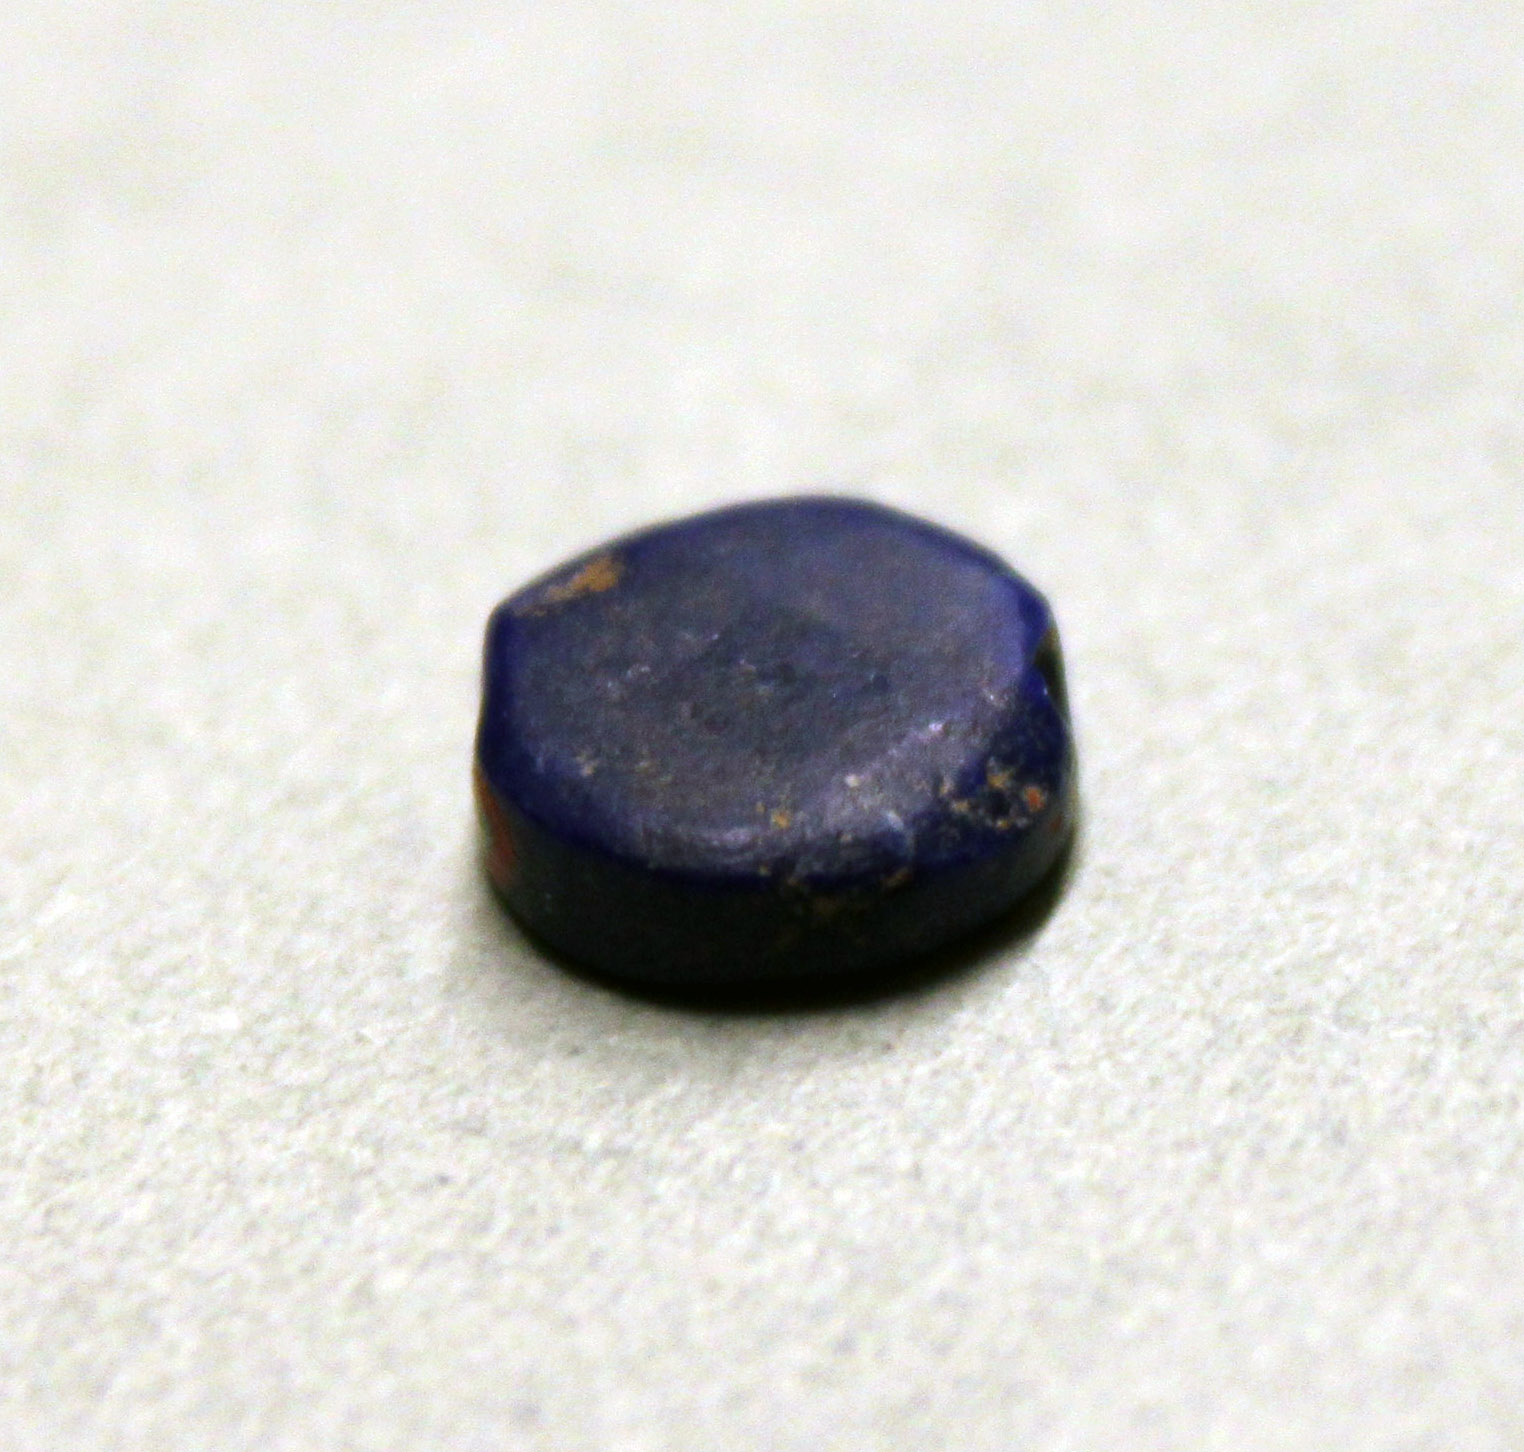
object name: bead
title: Beads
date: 801-1200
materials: lapis lazuli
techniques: cutting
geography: iran